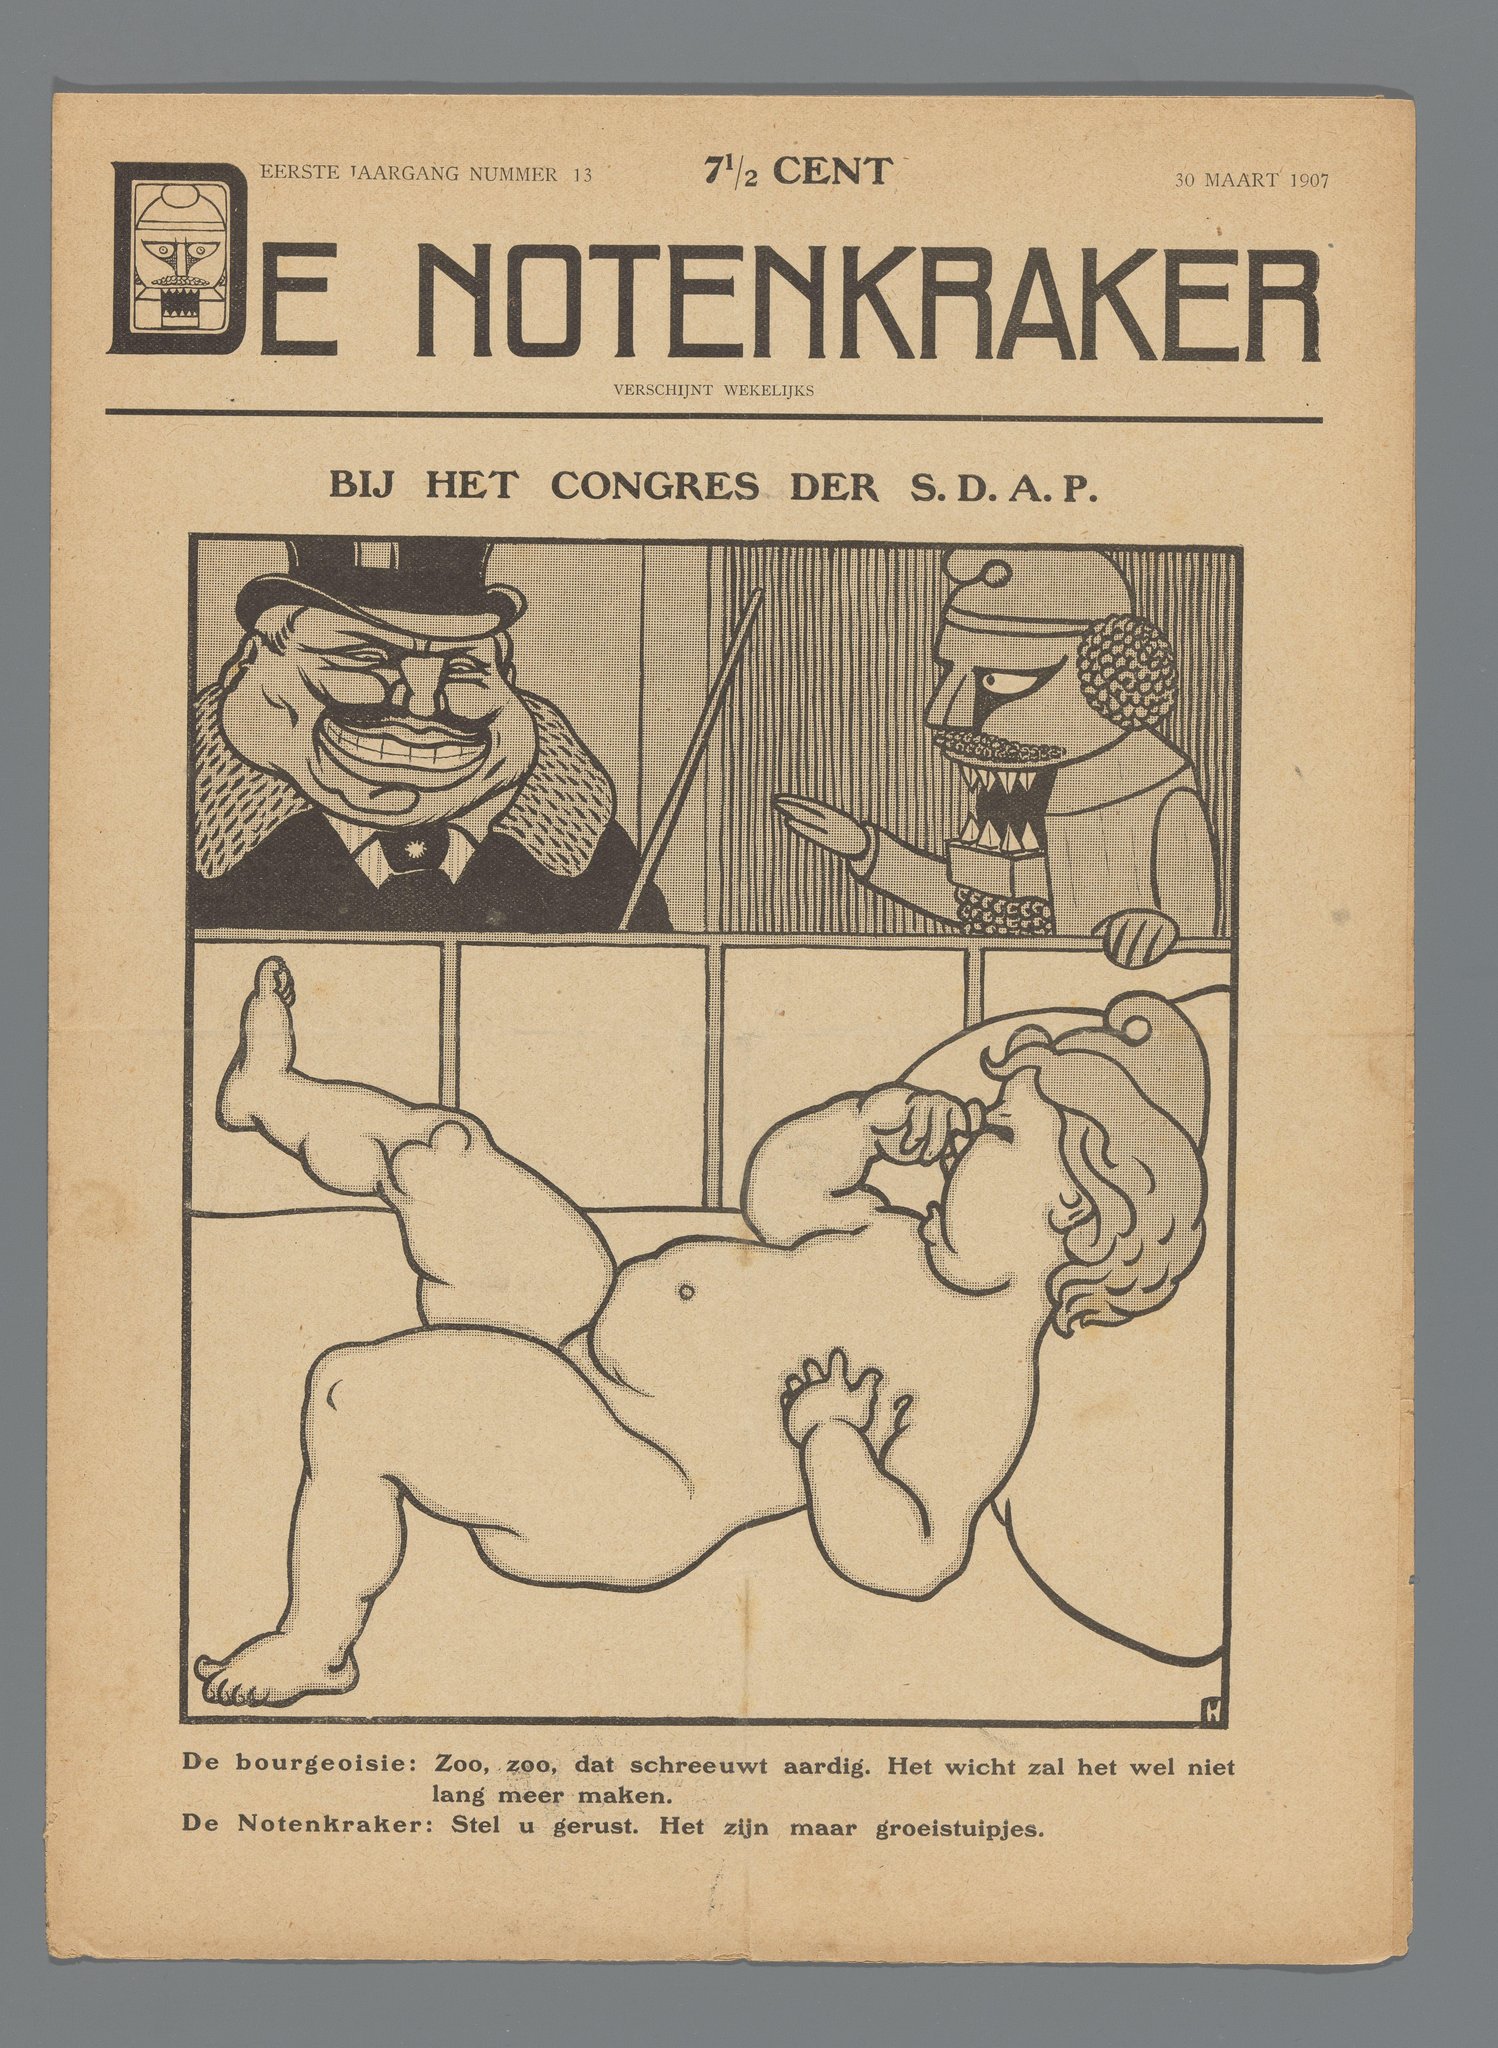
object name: print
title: De Notenkraker, 30 maart 1907 / Bij het congres der S.D.A.P.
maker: albert hahn (i)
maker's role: draughtsman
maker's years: 1877-1918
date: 1907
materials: paper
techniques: lithograph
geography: netherlands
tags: the rich, phrygian bonnet, freedom, liberty; 'libertà' (ripa), political parties, political caricatures and satires, netherlands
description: Aflevering van het satirische tijdschrift De Notenkraker van 30 maart 1907, eerste jaargang, nummer 13. Omslag met illustratie van een grijnzende rijke man van de bourgeoisie, de Notenkraker en een huilend kind met een vrijheidsmuts (SDAP). Onderdeel van een volledige eerste jaargang (1907). Elk nummer bevat 8 bladzijden, deels nog niet losgesneden, met op de voorzijde steeds een spotprent van Albert Hahn, op de overige pagina's prenten van Hahn steeds tussen de tekst. In de letter 'D' van de titel is een kop van een zgn. notenkraker afgebeeld.